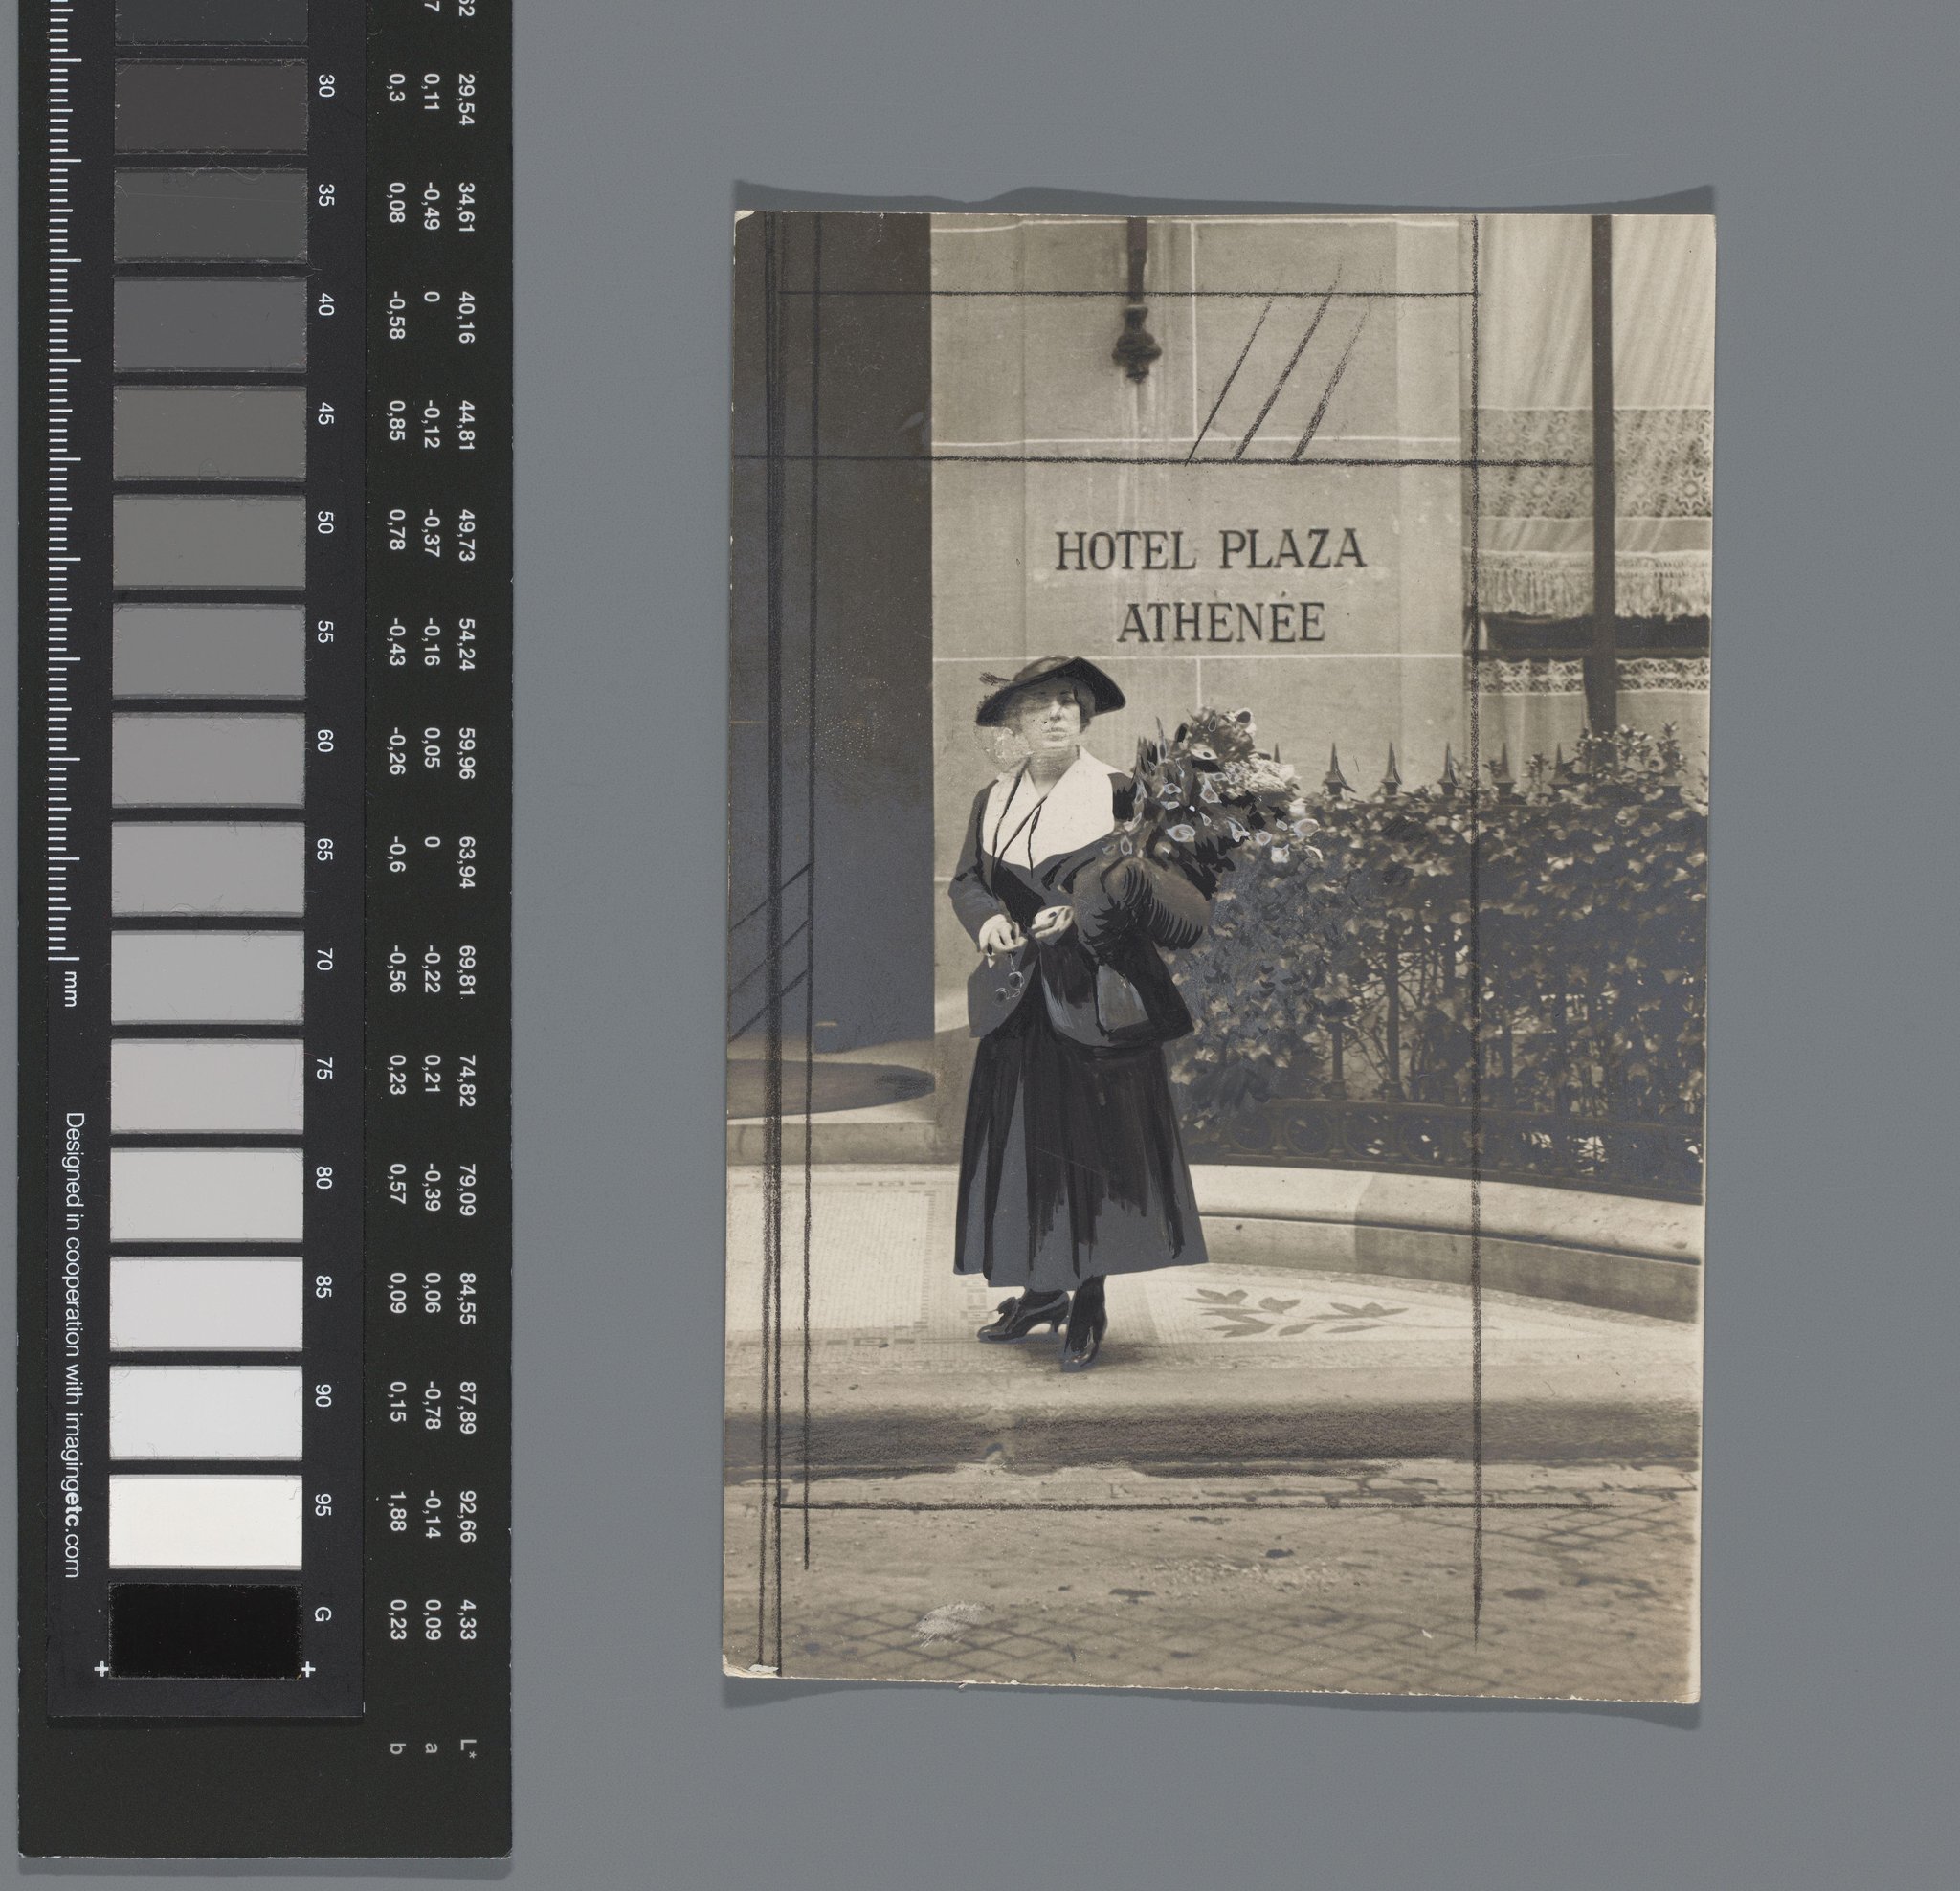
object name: photograph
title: Vrouw op straat met een boeket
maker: Anonymous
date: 1916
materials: ink, photographic support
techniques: gelatin silver print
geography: paris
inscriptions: stamp: ‘SOCIETE DE PETIT PARISIEN / DUPUY & Cie / 1 MAI 1916 / 18 Rue d’Enghien. PARIS’